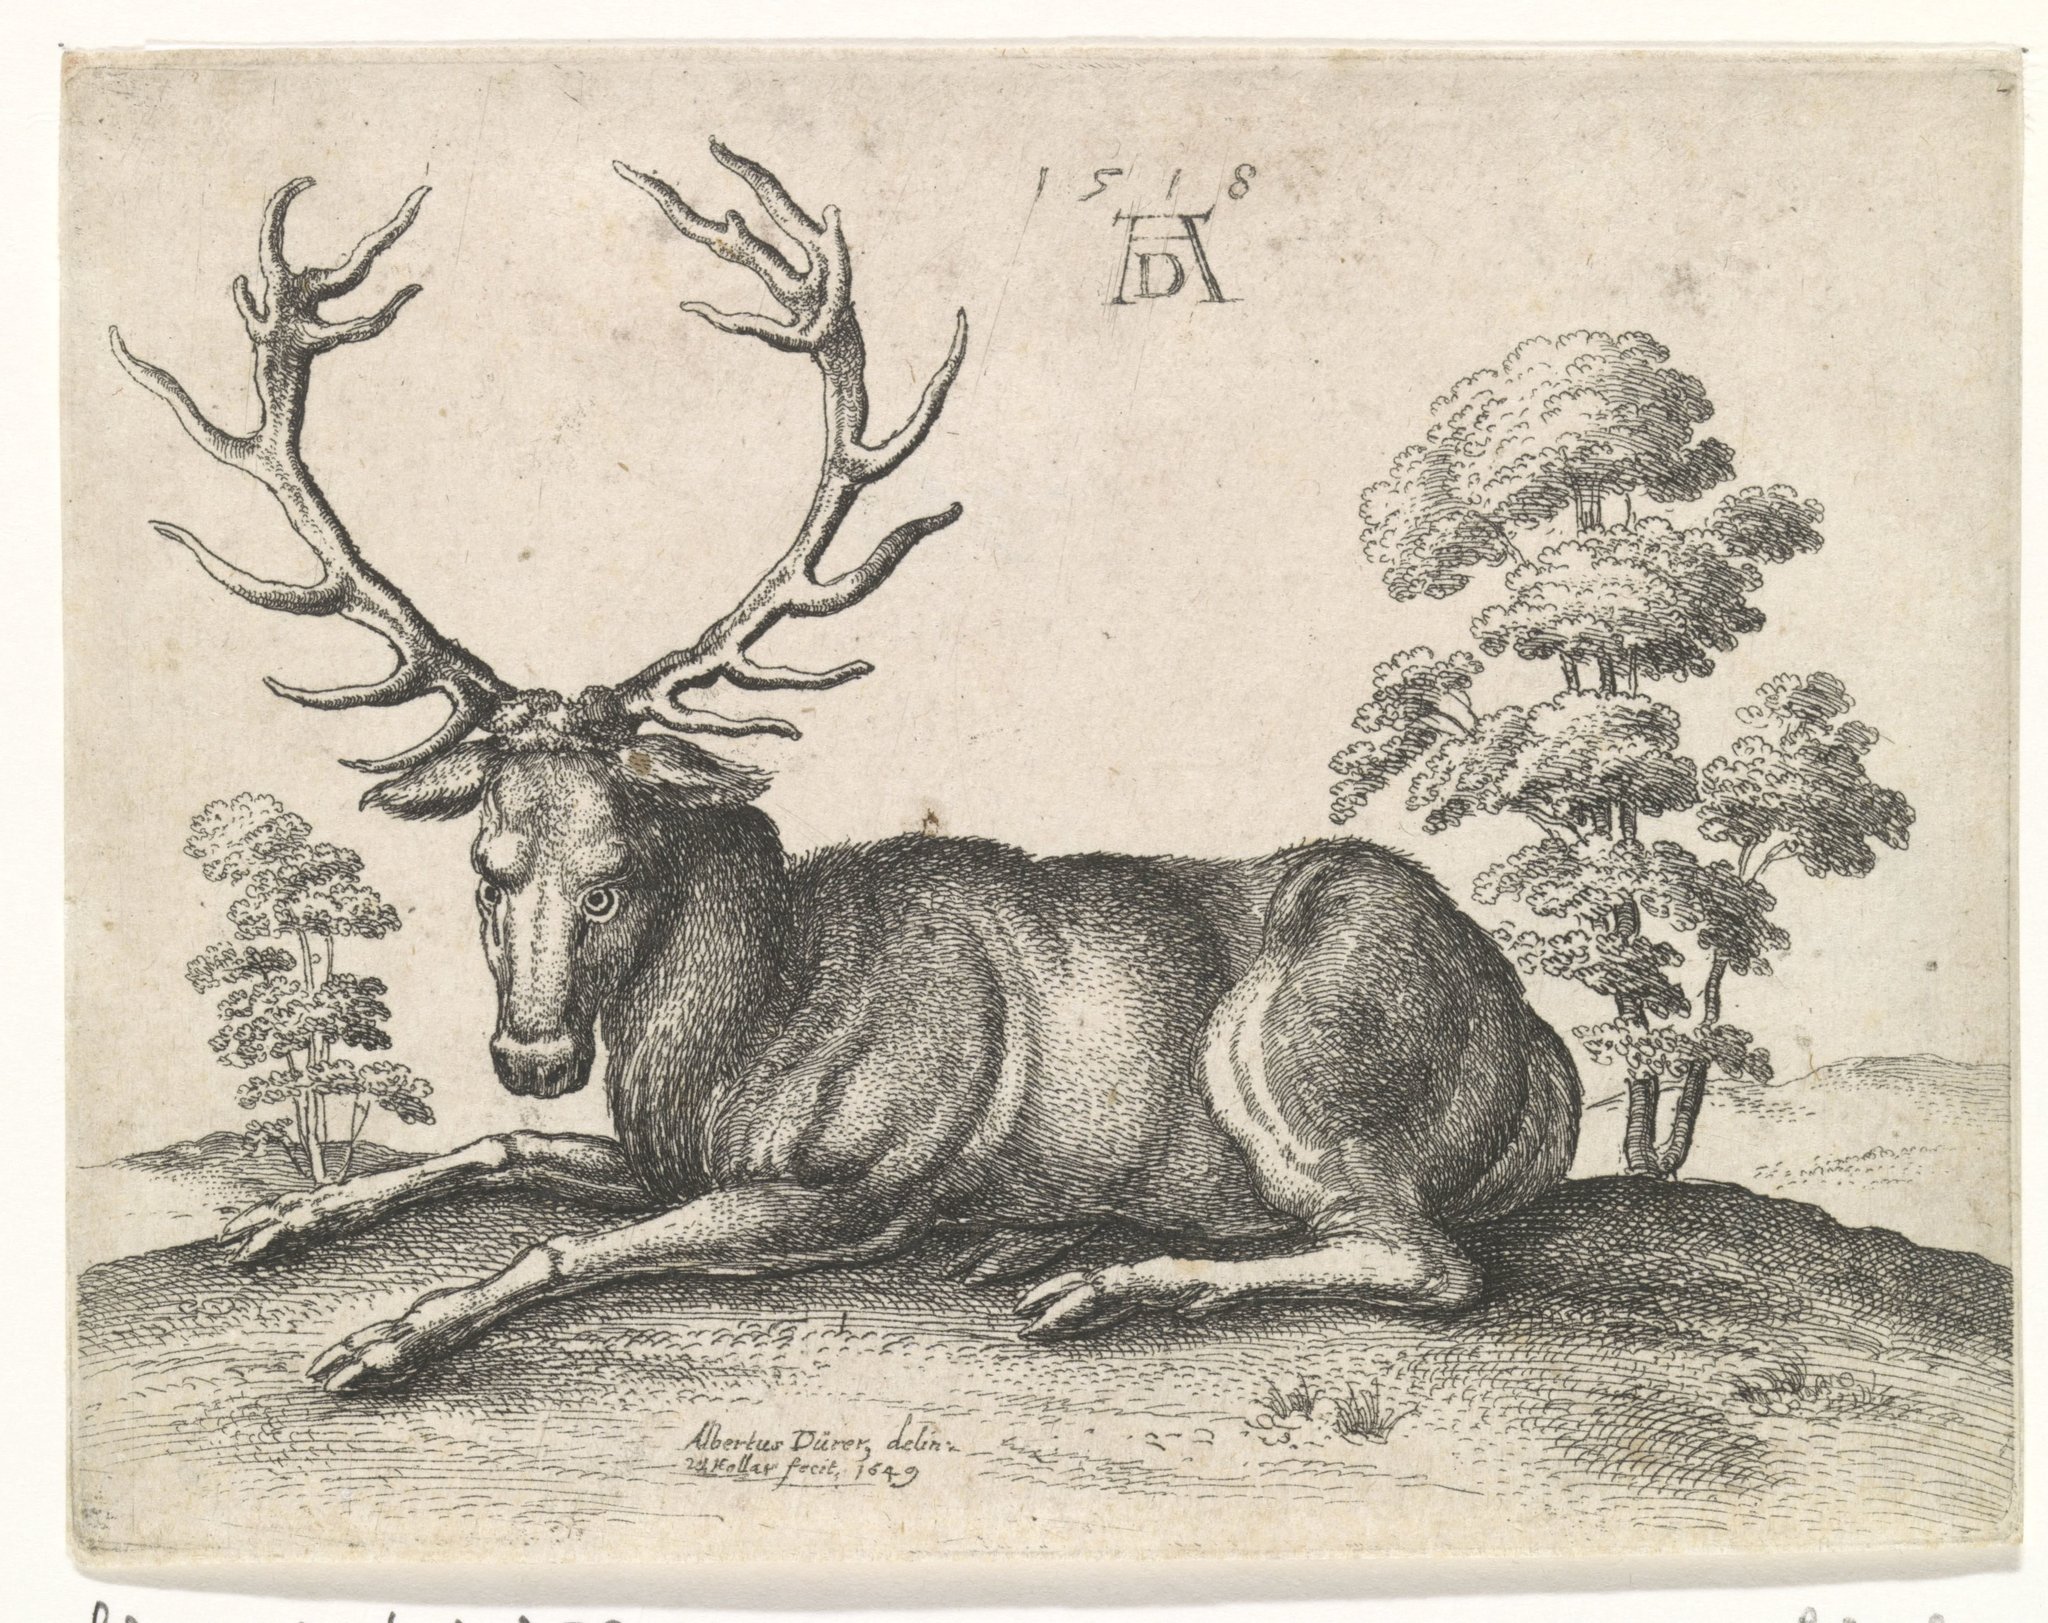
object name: print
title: Liggend hert, naar links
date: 1649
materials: paper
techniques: etching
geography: antwerp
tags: hoofed animals: deer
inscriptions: collector's mark: Lugt 240